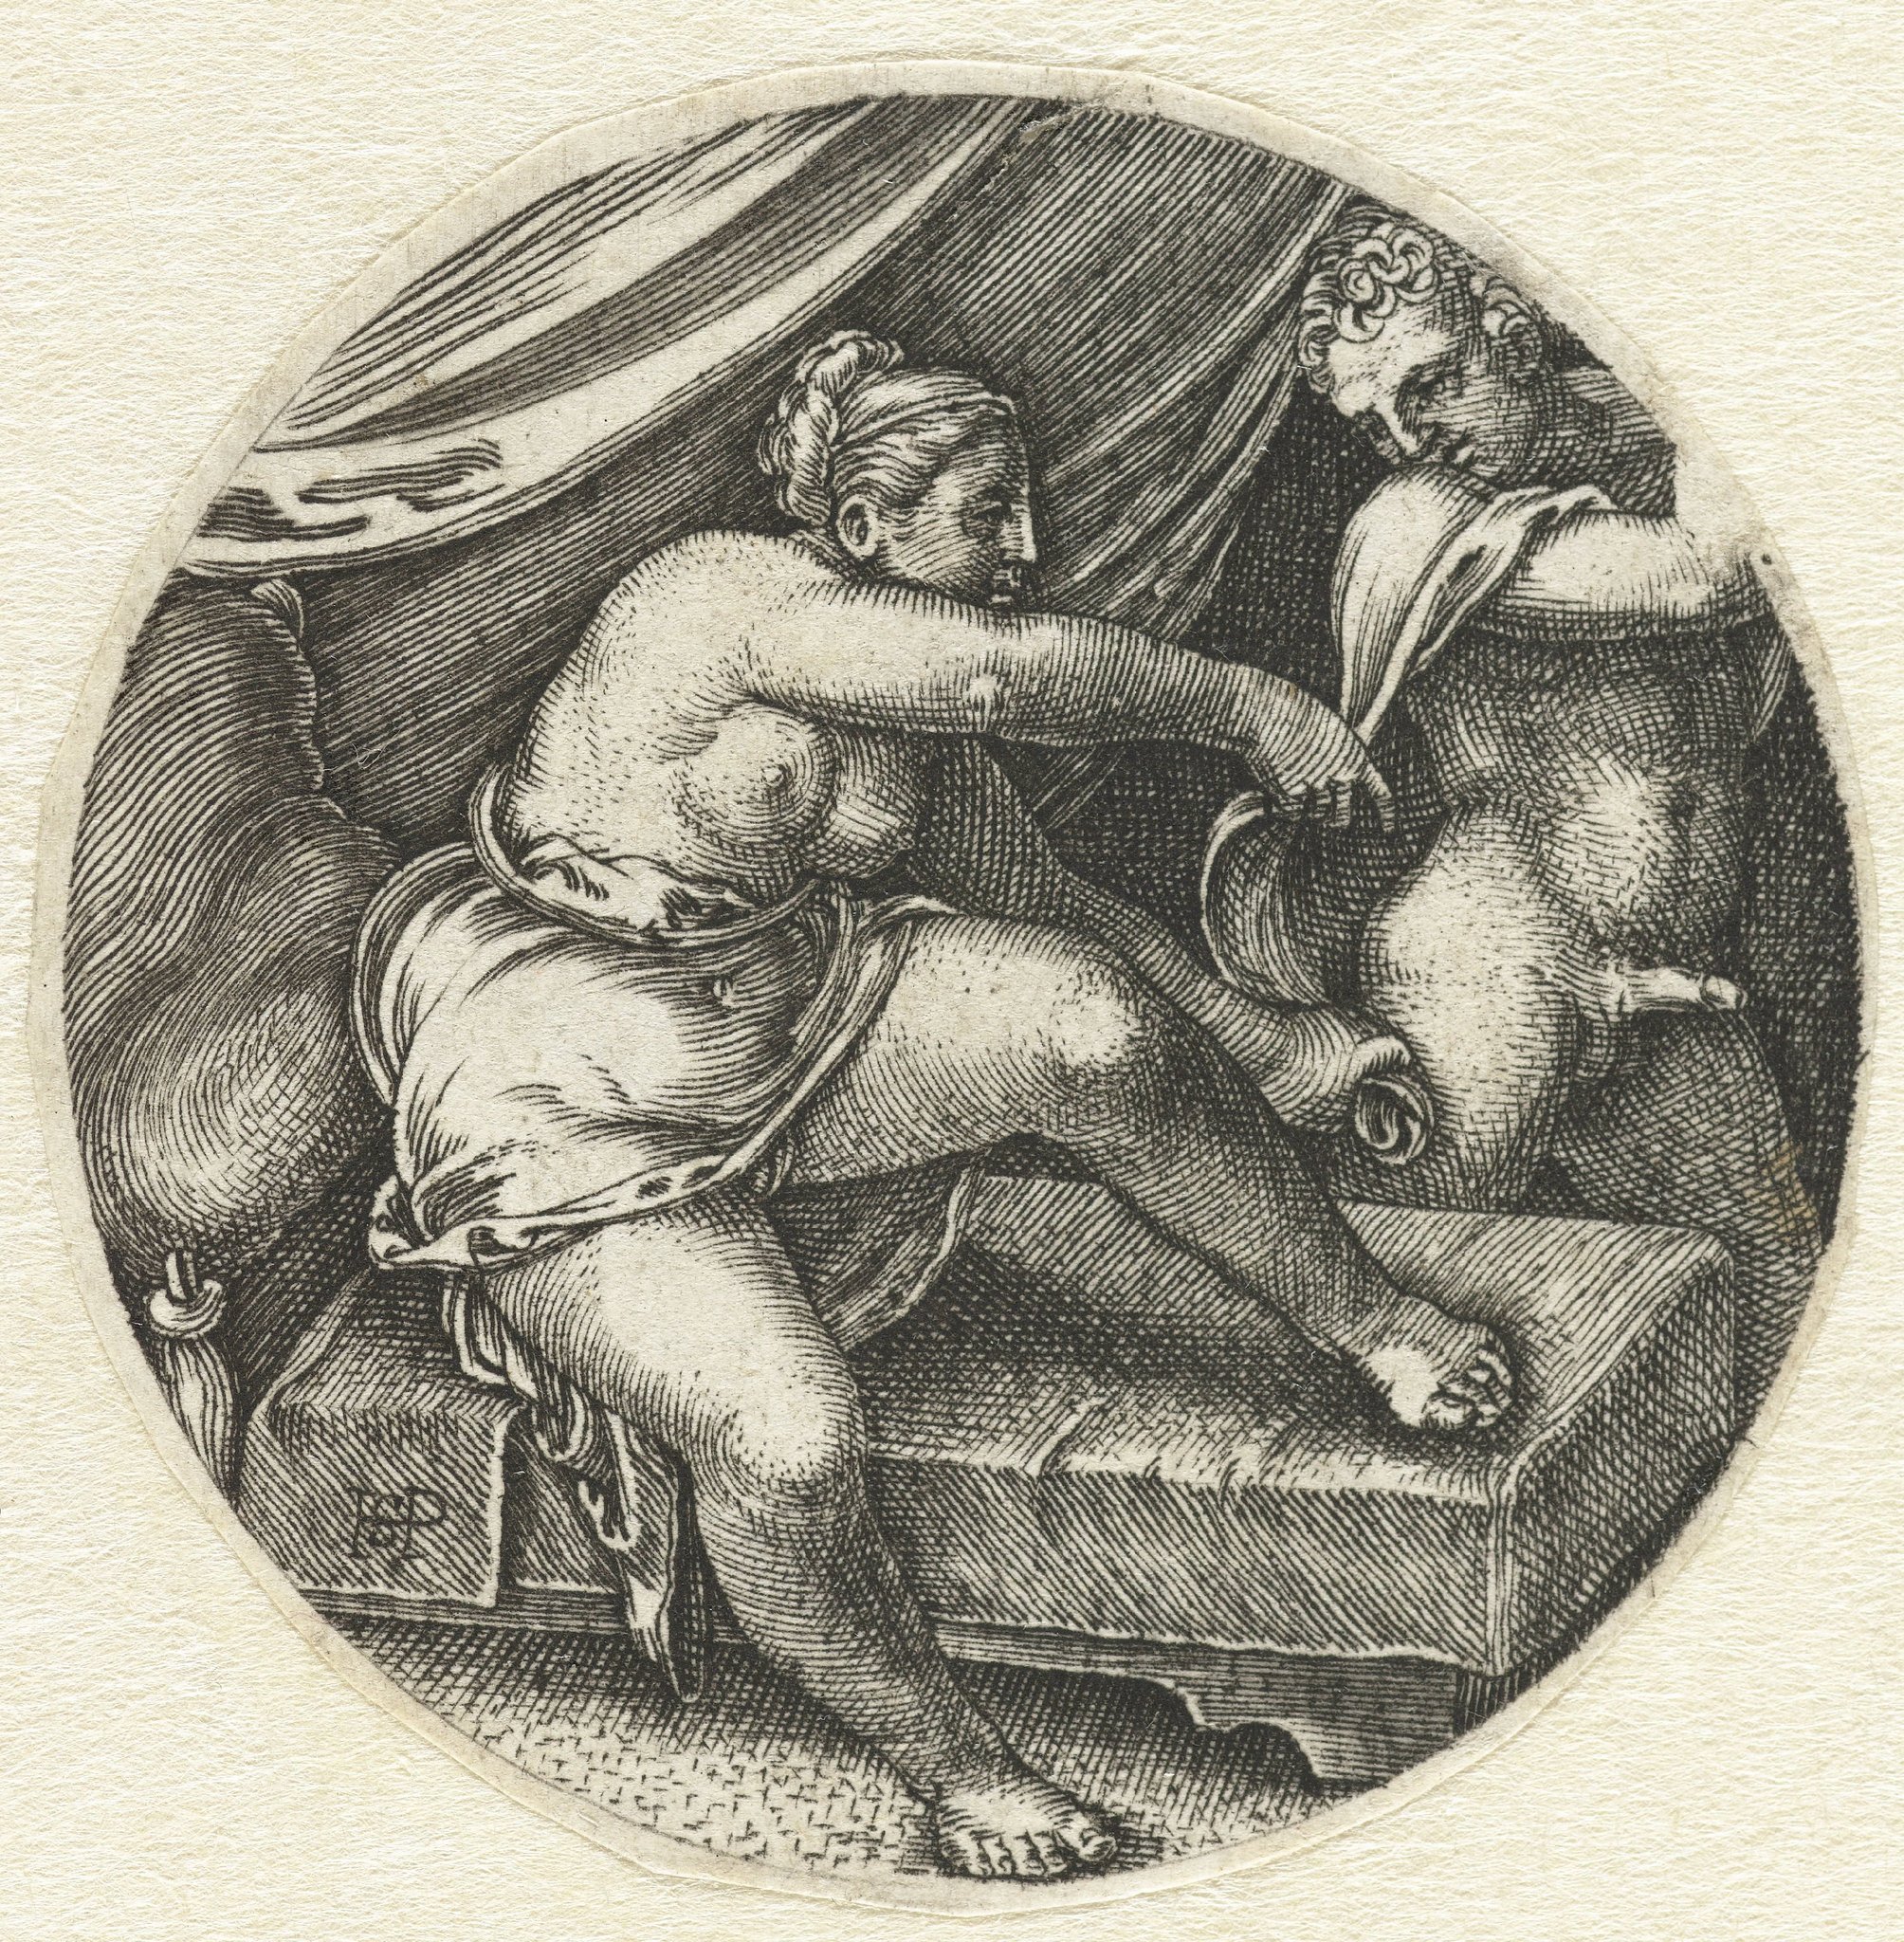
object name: print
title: Jozef en de vrouw van Potifar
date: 1526-1599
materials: paper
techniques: engraving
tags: potiphar's wife catches joseph by his robe, usually while lying in bed; joseph escapes leaving his cloak behind in her hands (possibly with a naked child lying in a crib)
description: Kopie in spiegelbeeld naar een prent van Hans Sebald Beham waarop het opschrift van de originele prent IOSEPH ontbreekt.